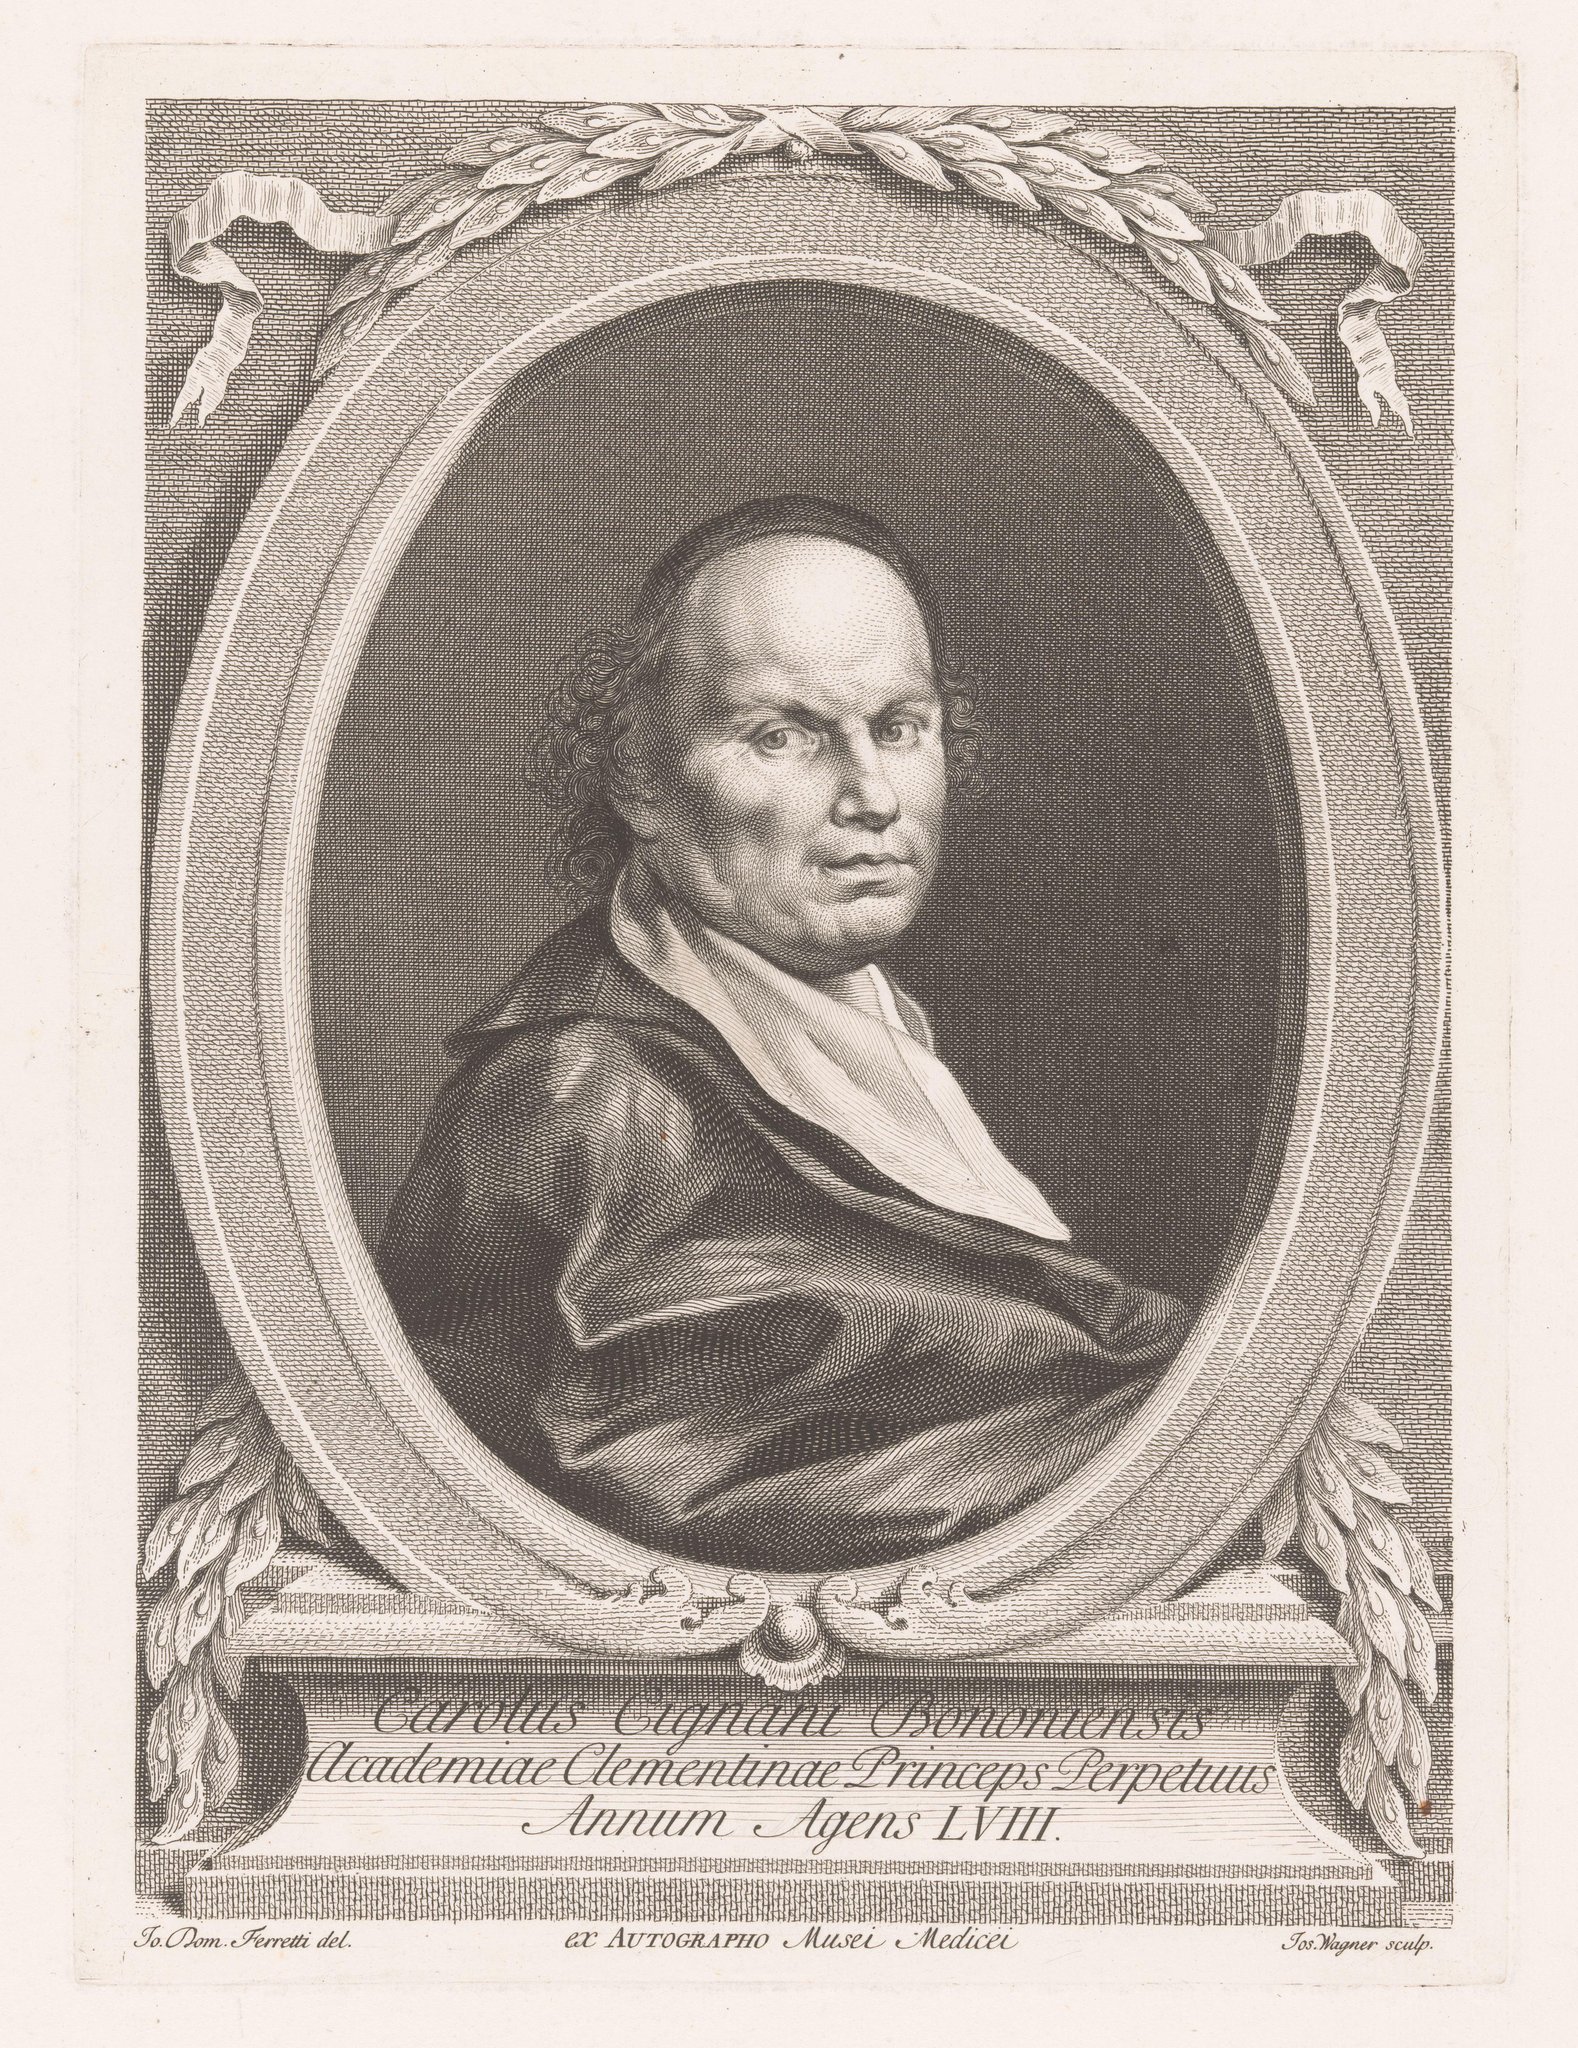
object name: print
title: Portret van Carlo Cignani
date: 1716-1780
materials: paper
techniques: engraving, etching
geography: venice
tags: draughtsman, carlo cignani, historical persons, portrait, self-portrait of artist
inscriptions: collector's mark: Lugt 2228